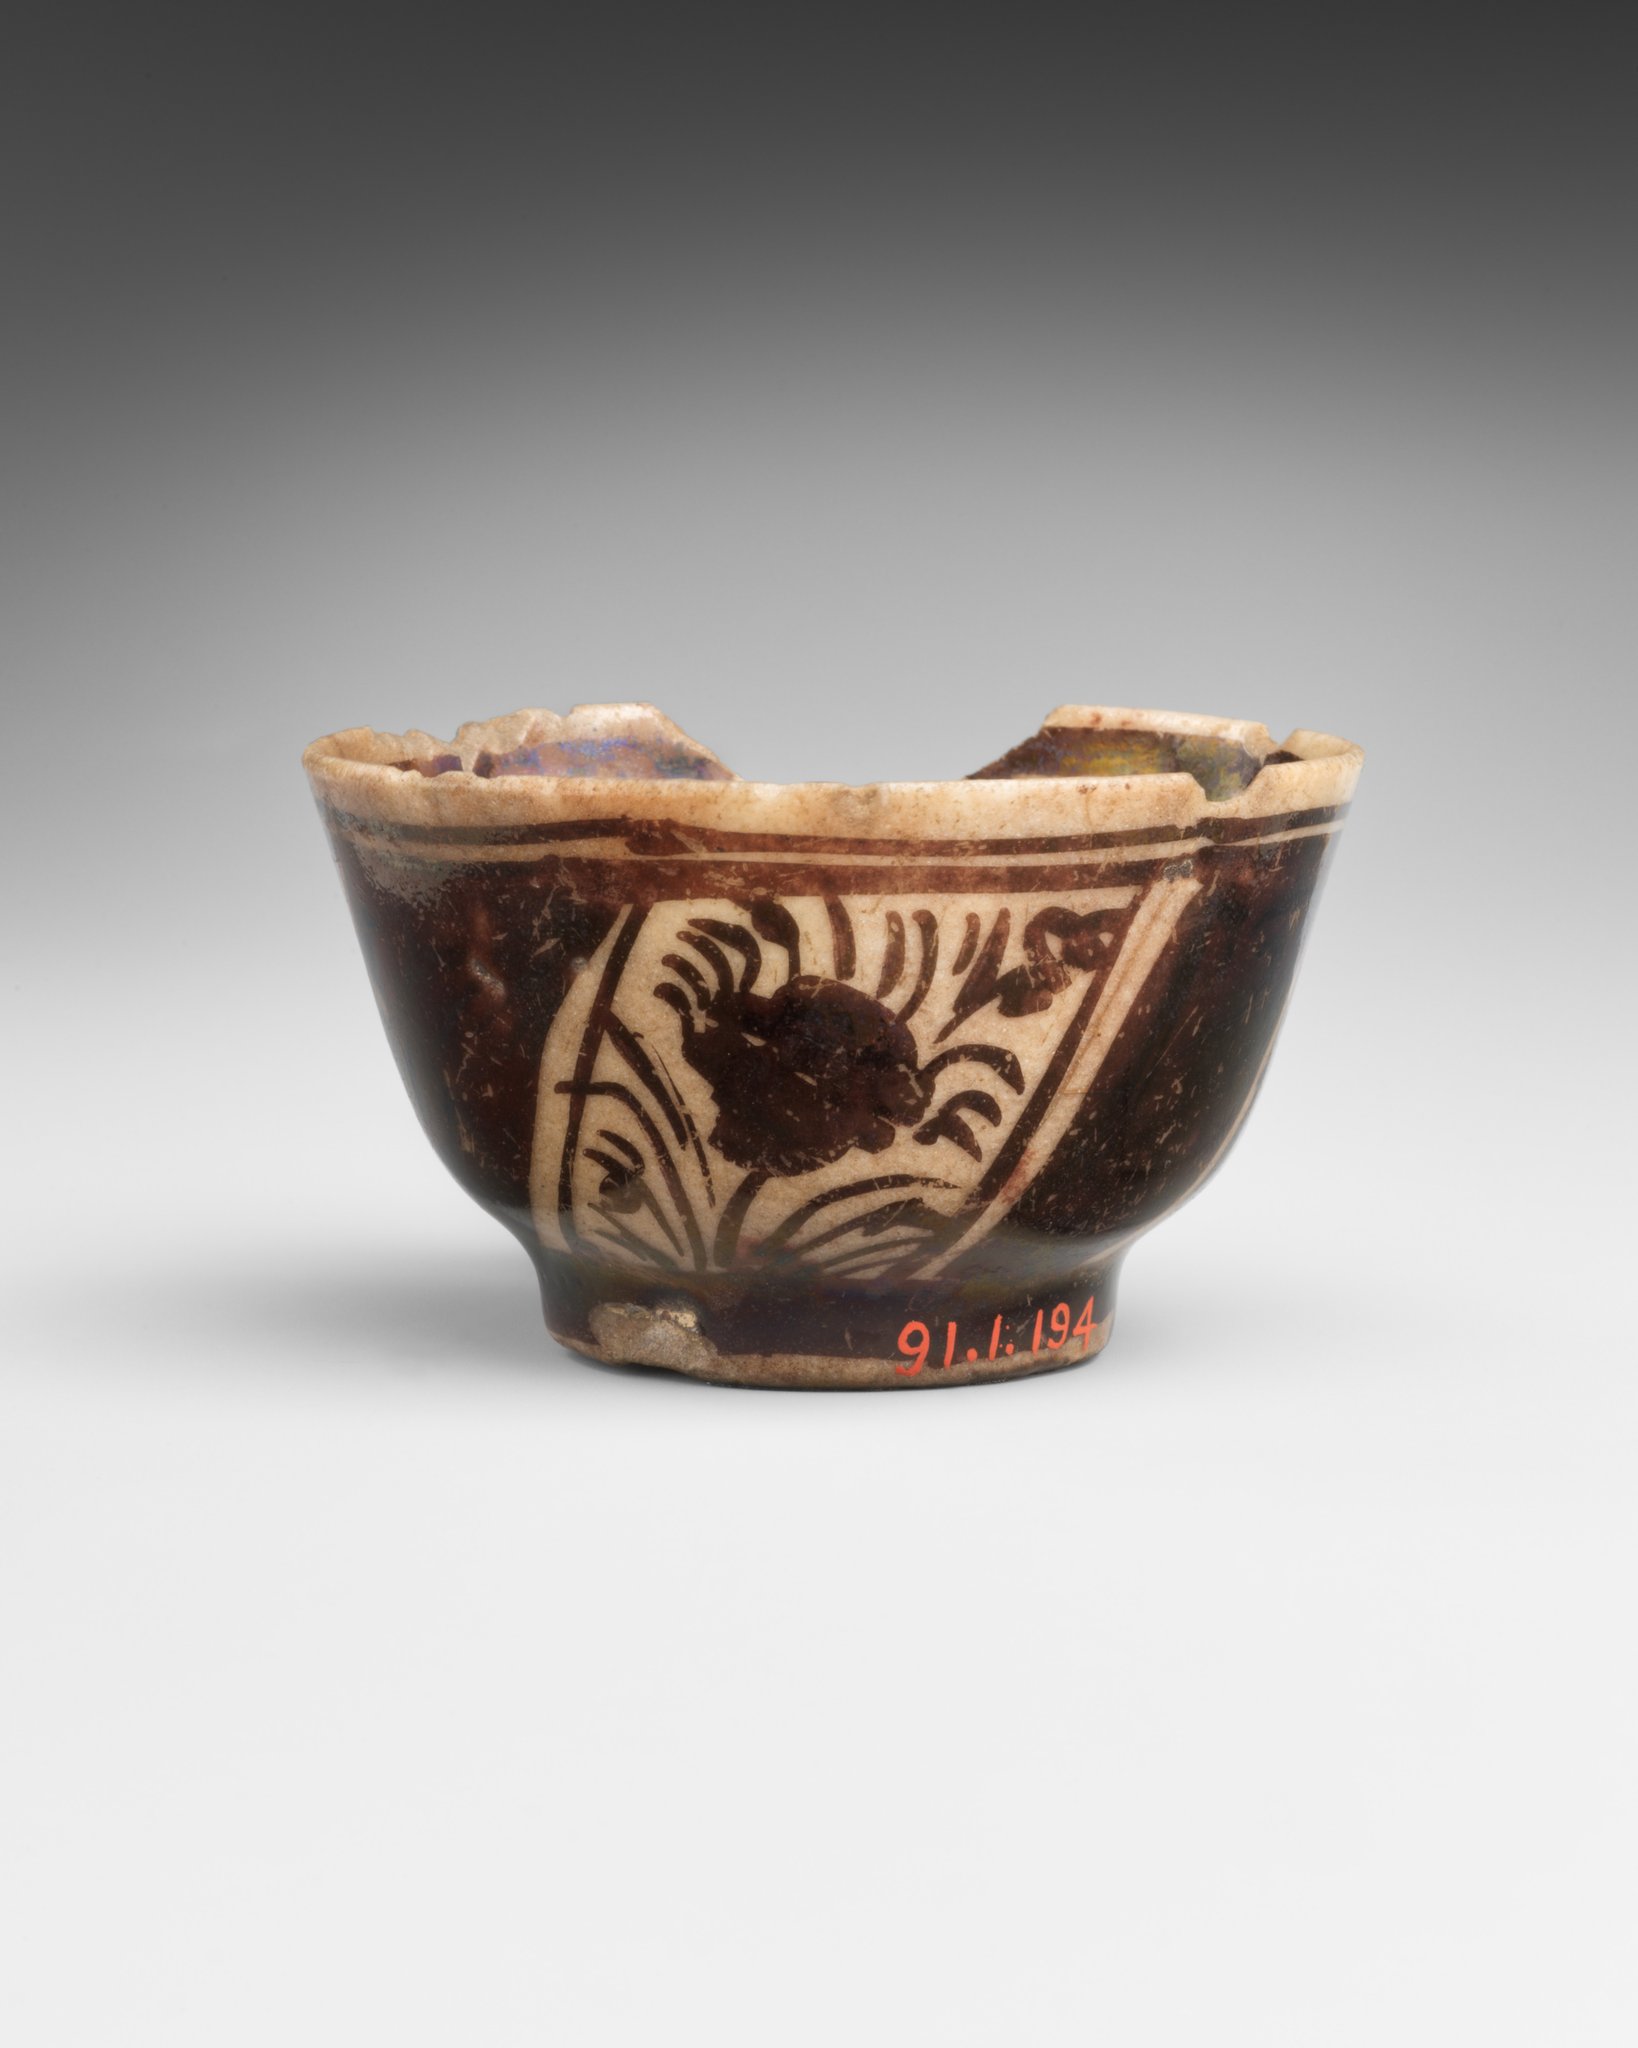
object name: cup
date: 1701-1800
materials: glaze, stonepaste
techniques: luster painting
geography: iran